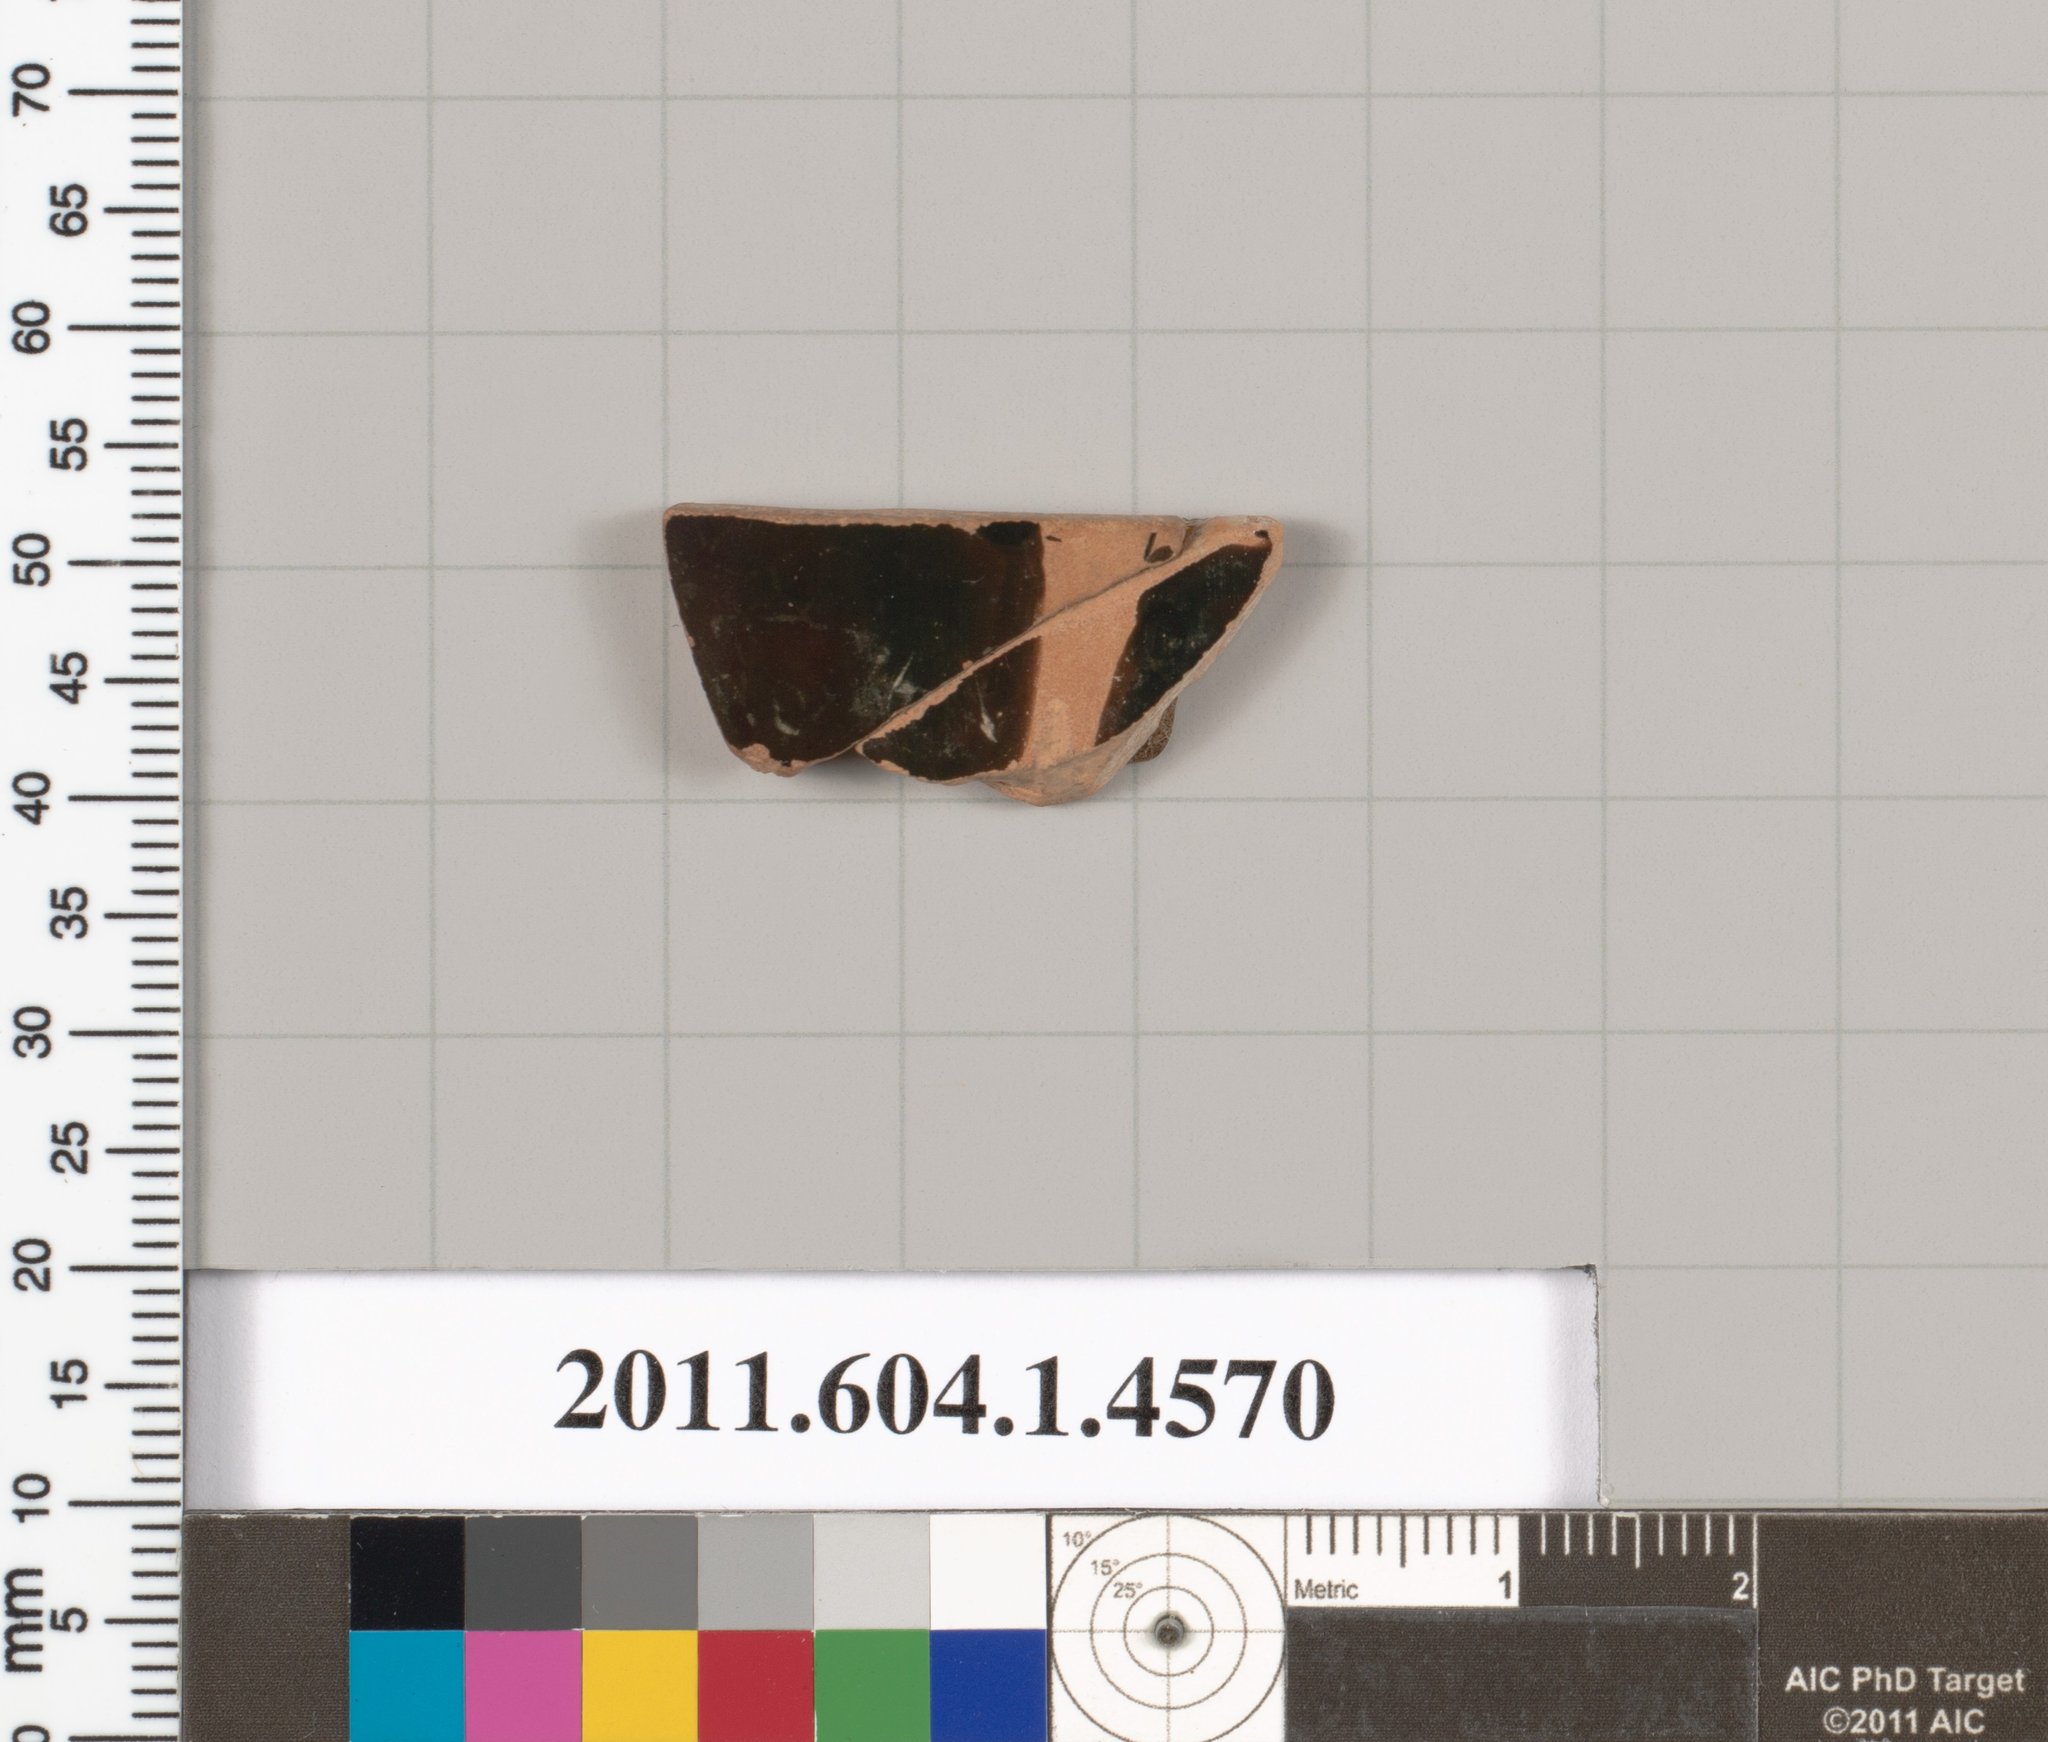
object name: kylix fragment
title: Terracotta fragment of a kylix (drinking cup)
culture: greek, attic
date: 475-451 BCE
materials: terracotta